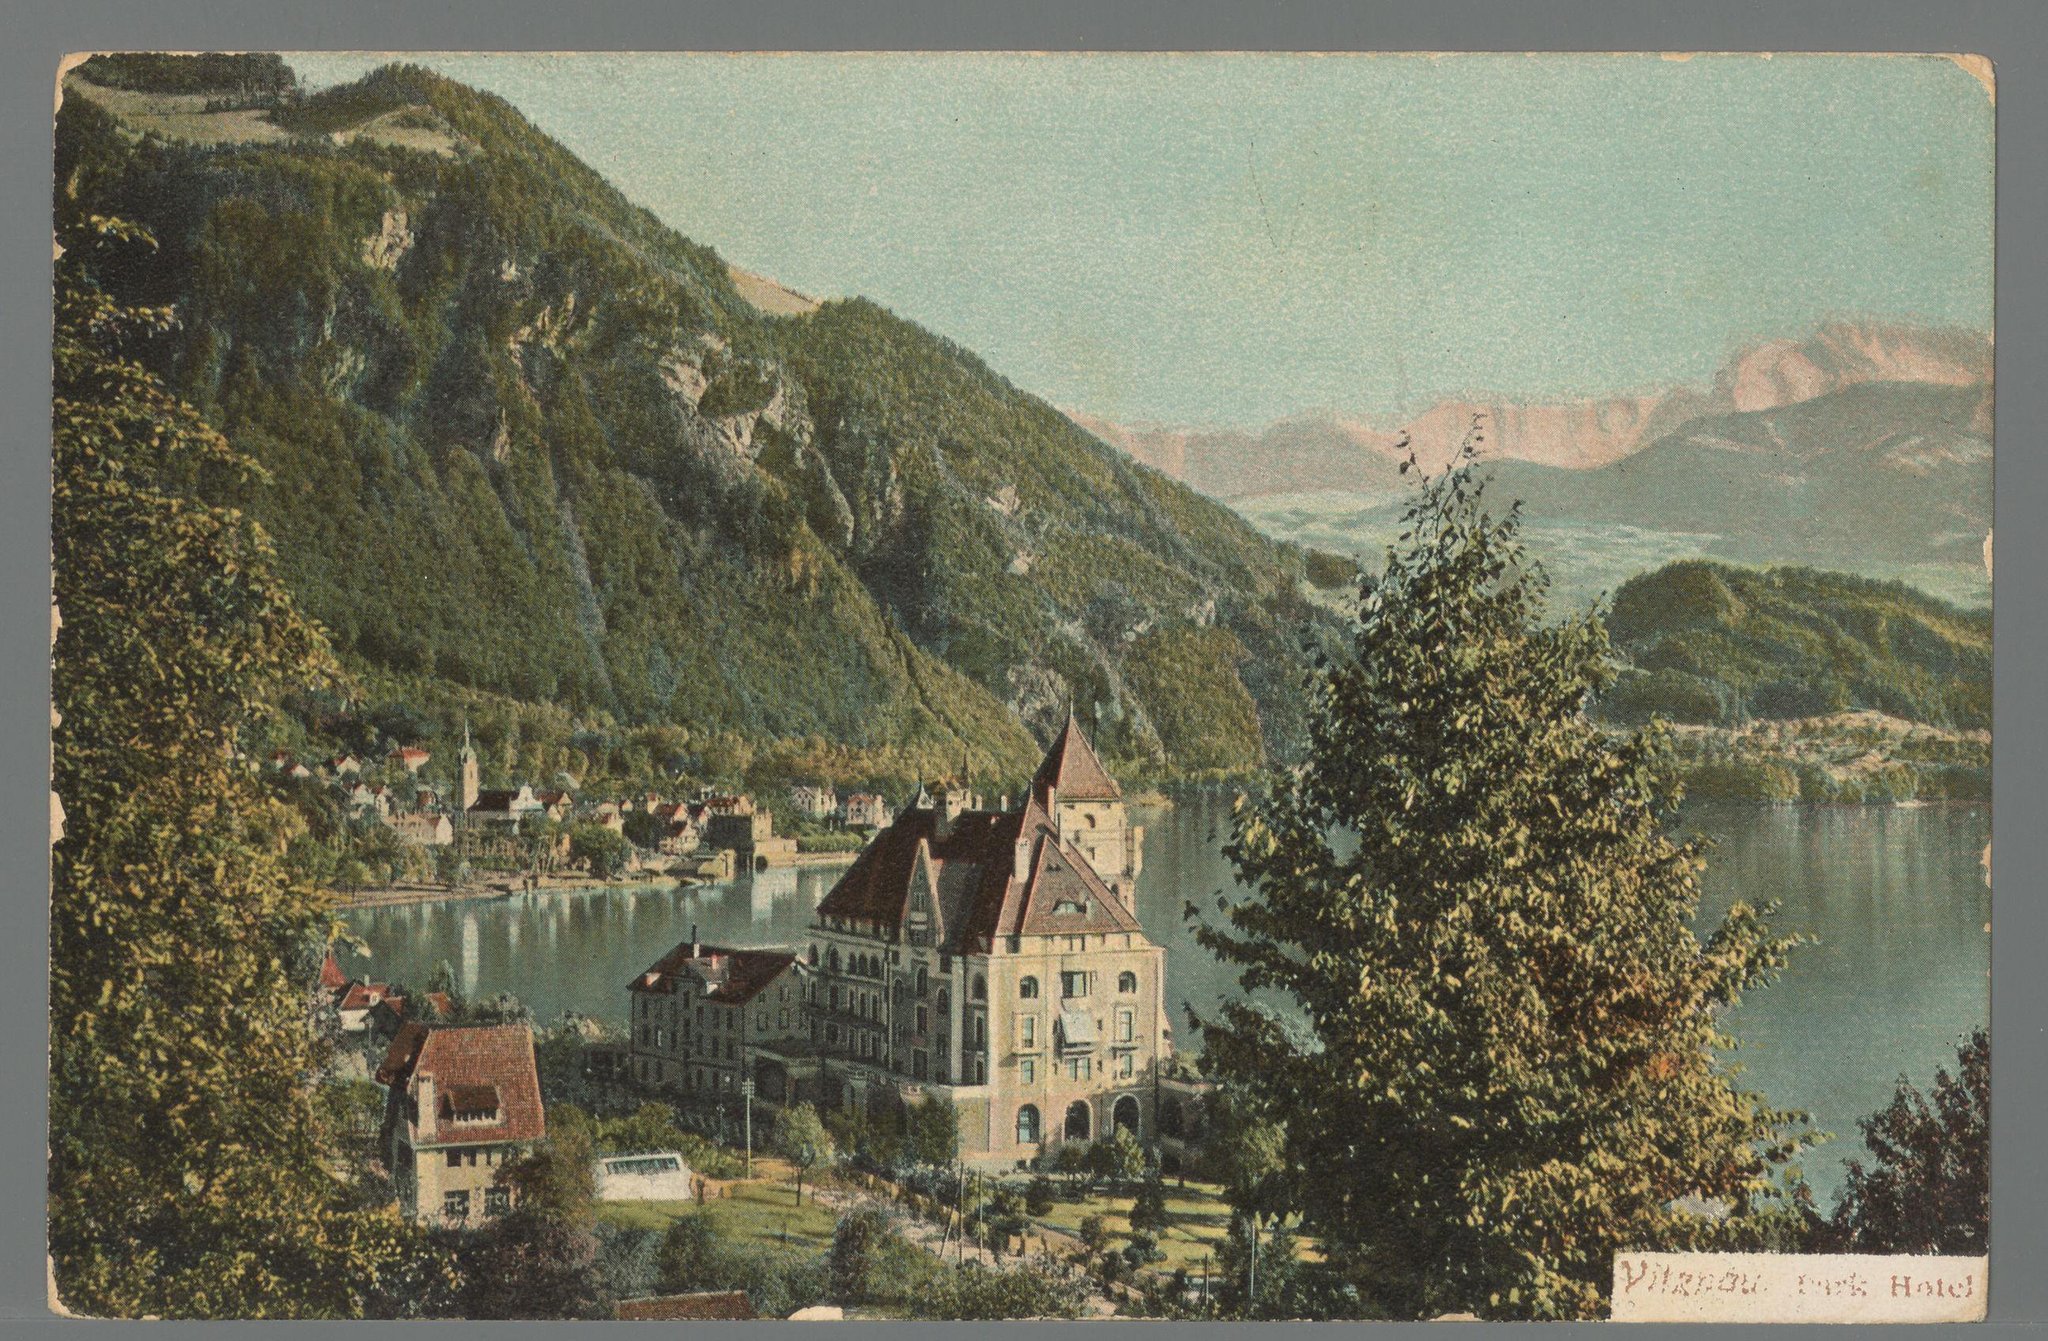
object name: photomechanical print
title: Vitznau. Park Hotel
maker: louis glaser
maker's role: printer, publisher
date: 1903-1904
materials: cardboard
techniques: lithograph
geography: vitznau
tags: lake, mountain-range, snow peaks, prospect of city, town panorama, silhouette of city